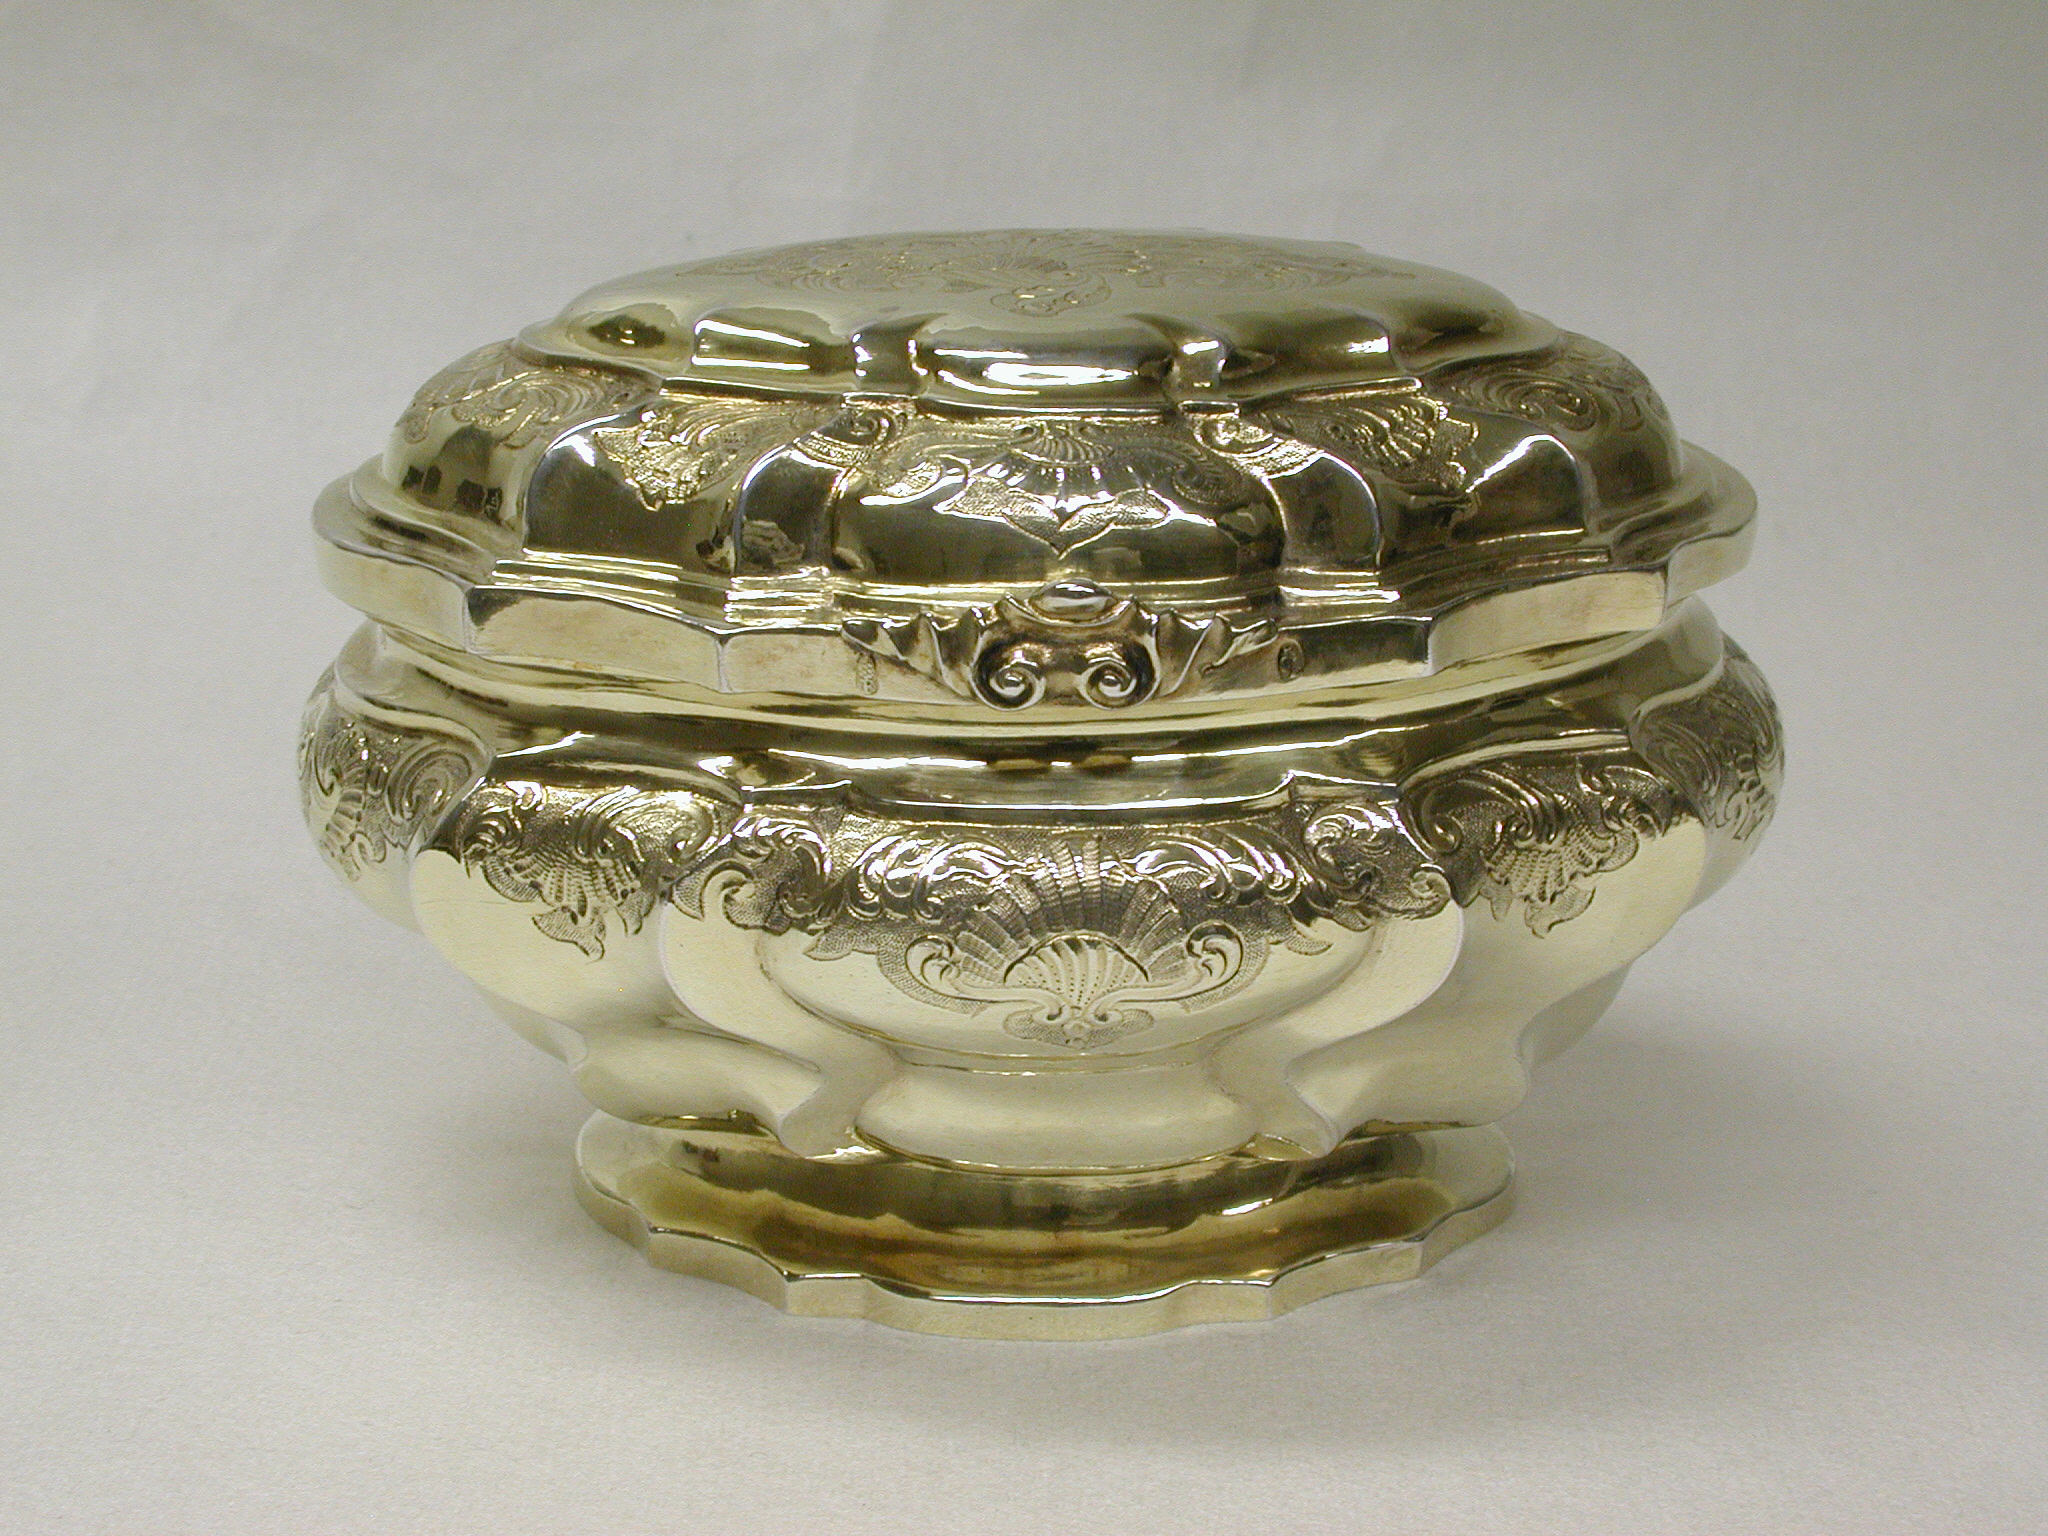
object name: toilet box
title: Toilet box (one of a pair)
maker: johann conrad lotter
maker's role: maker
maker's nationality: german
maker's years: 1738-1779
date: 1743-1745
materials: silver gilt